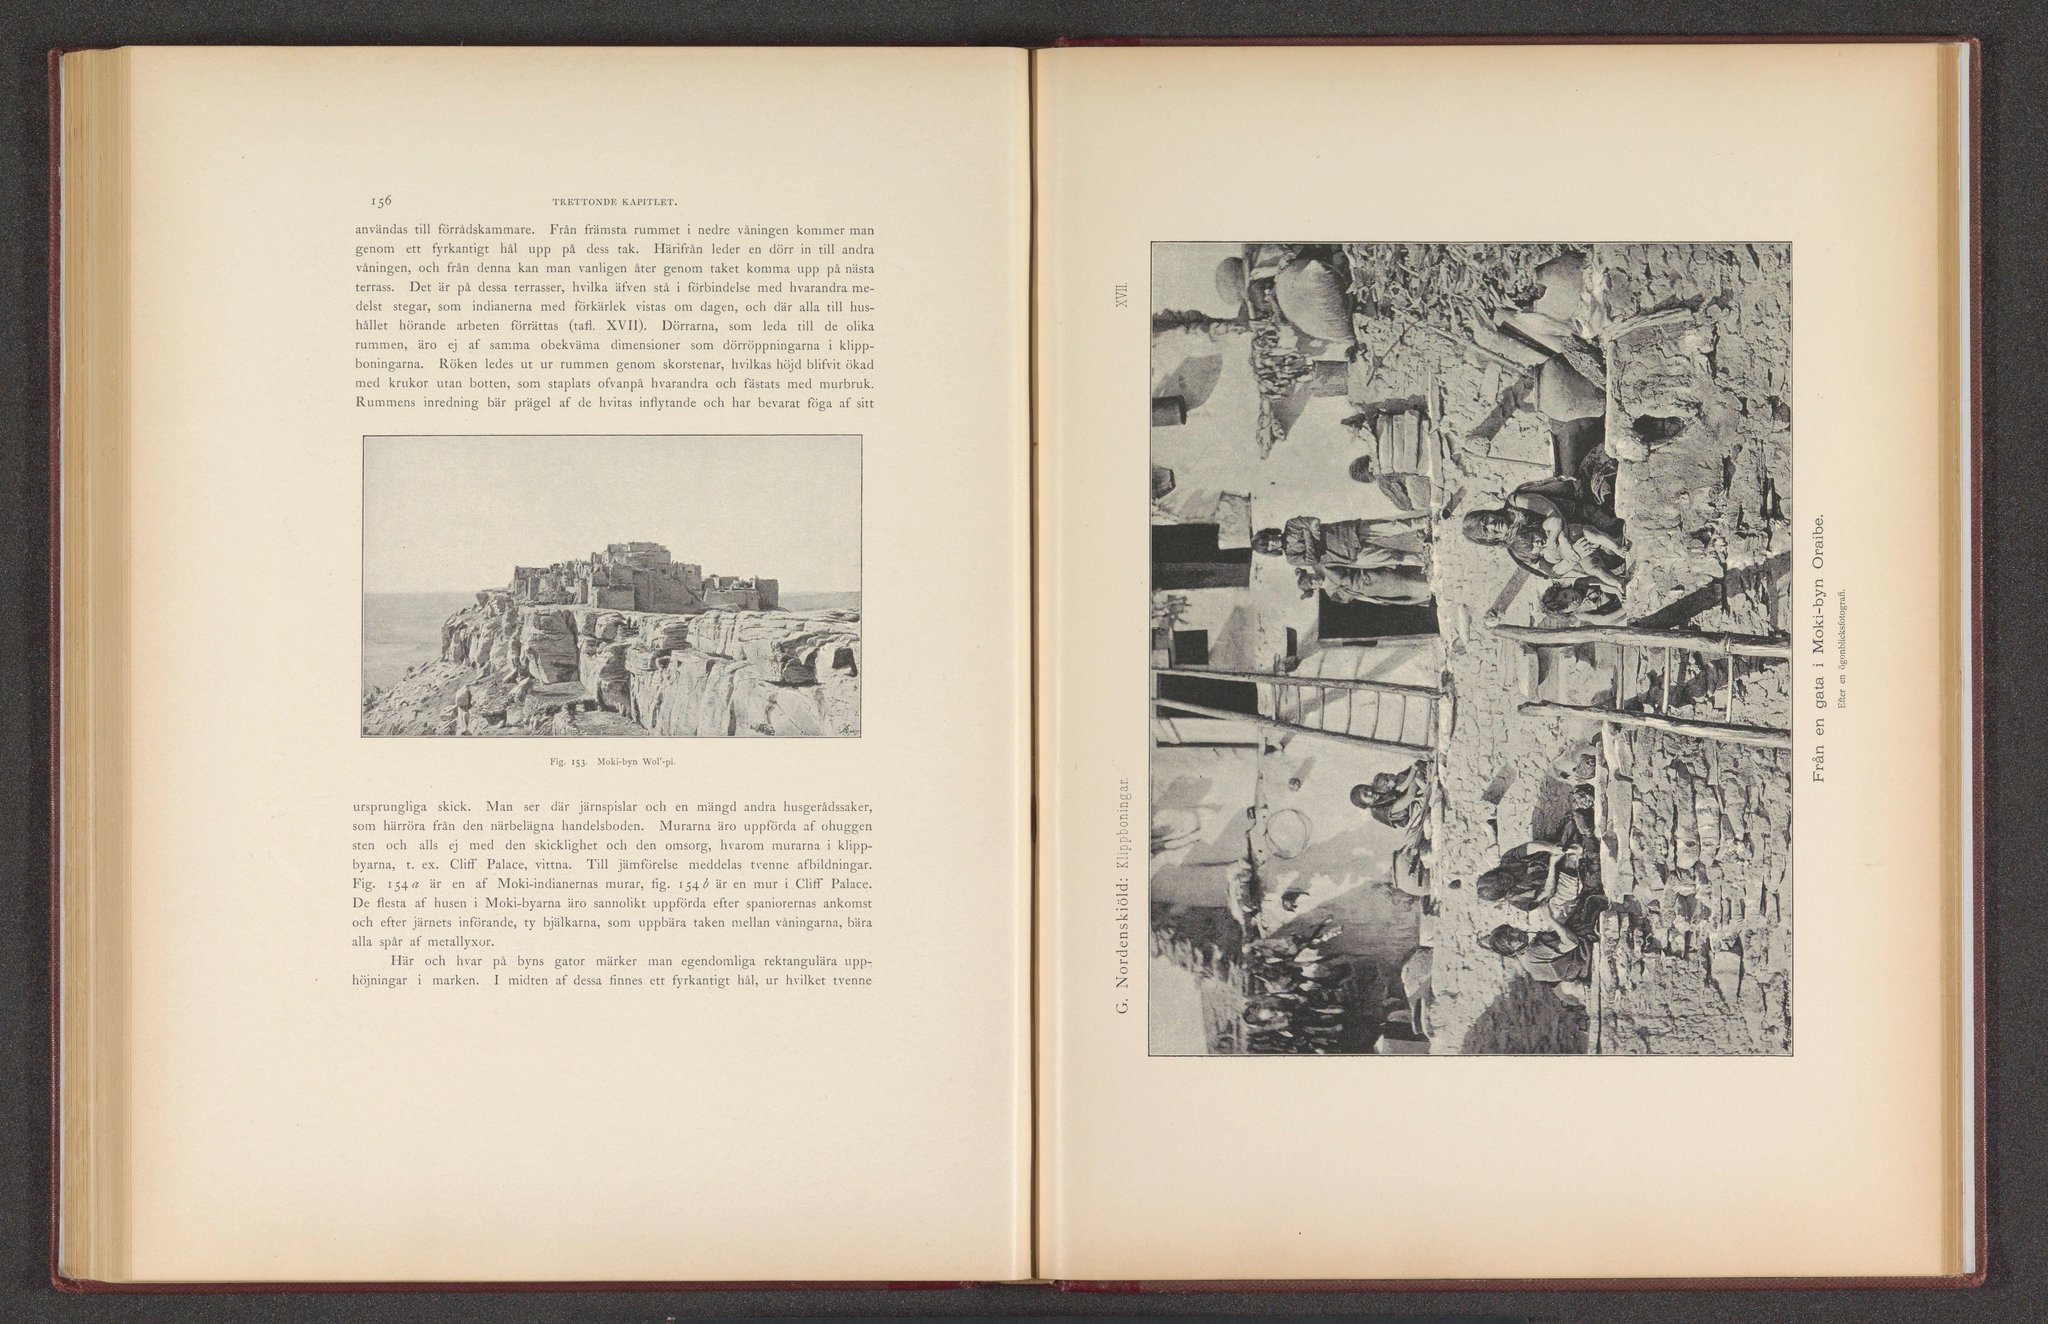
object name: page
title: Gezicht op een dorp van het Hopi-volk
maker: gustaf nordenskiöld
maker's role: fotograaf, schrijver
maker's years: 1868-1895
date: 1891-1893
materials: paper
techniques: autotype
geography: vienna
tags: prospect of village, silhouette of village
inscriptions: name, number: ‘Fig. 153.’